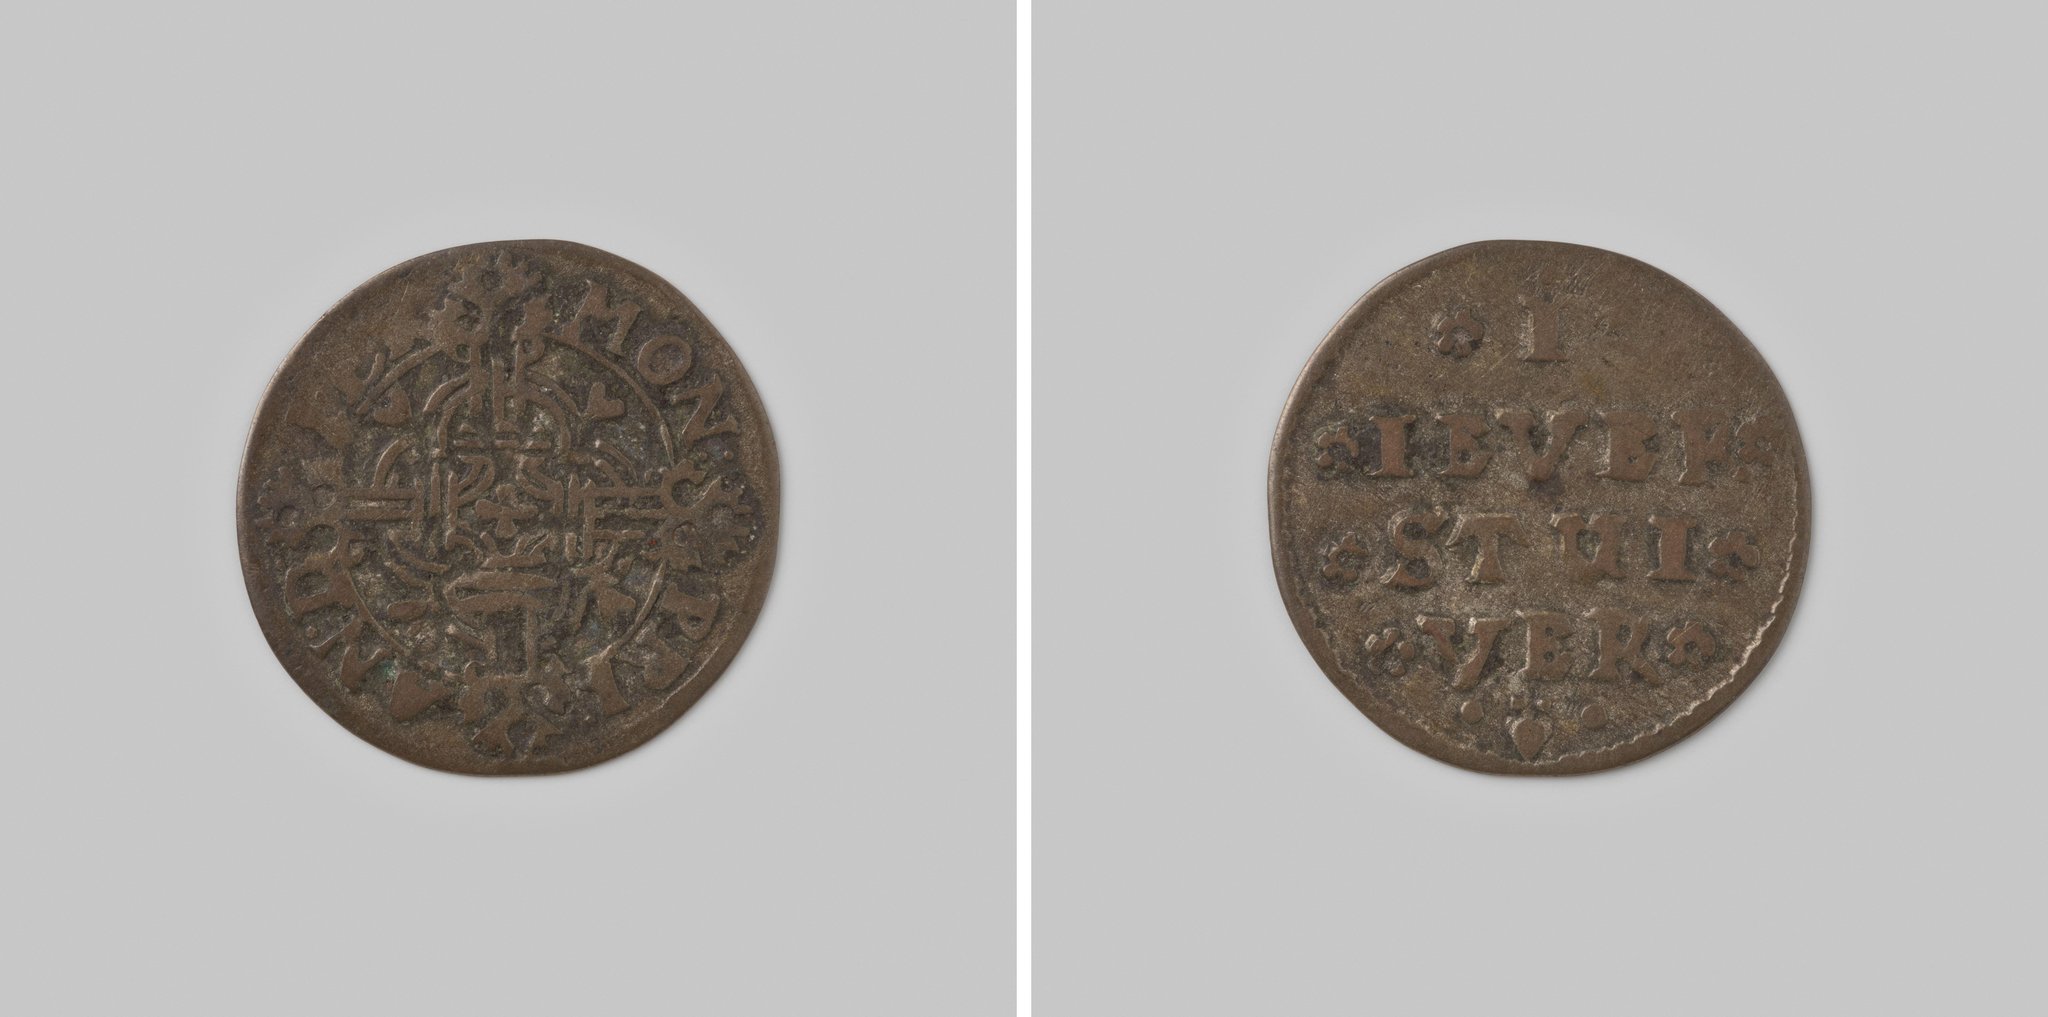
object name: coin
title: Heerlijkheid Jever, Karl Wilhelm van Anhalt-Zerbst, stuiver, 1667-1718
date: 1677-1718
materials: copper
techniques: striking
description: Koperen munt. Voorzijde: op vierpas lang versierd kruis. In het centrum een bloem, in de hoeken harten. Keerzijde: waarde-aanduiding: I JEVER STUI/VER in vier regels. Gladde rand.